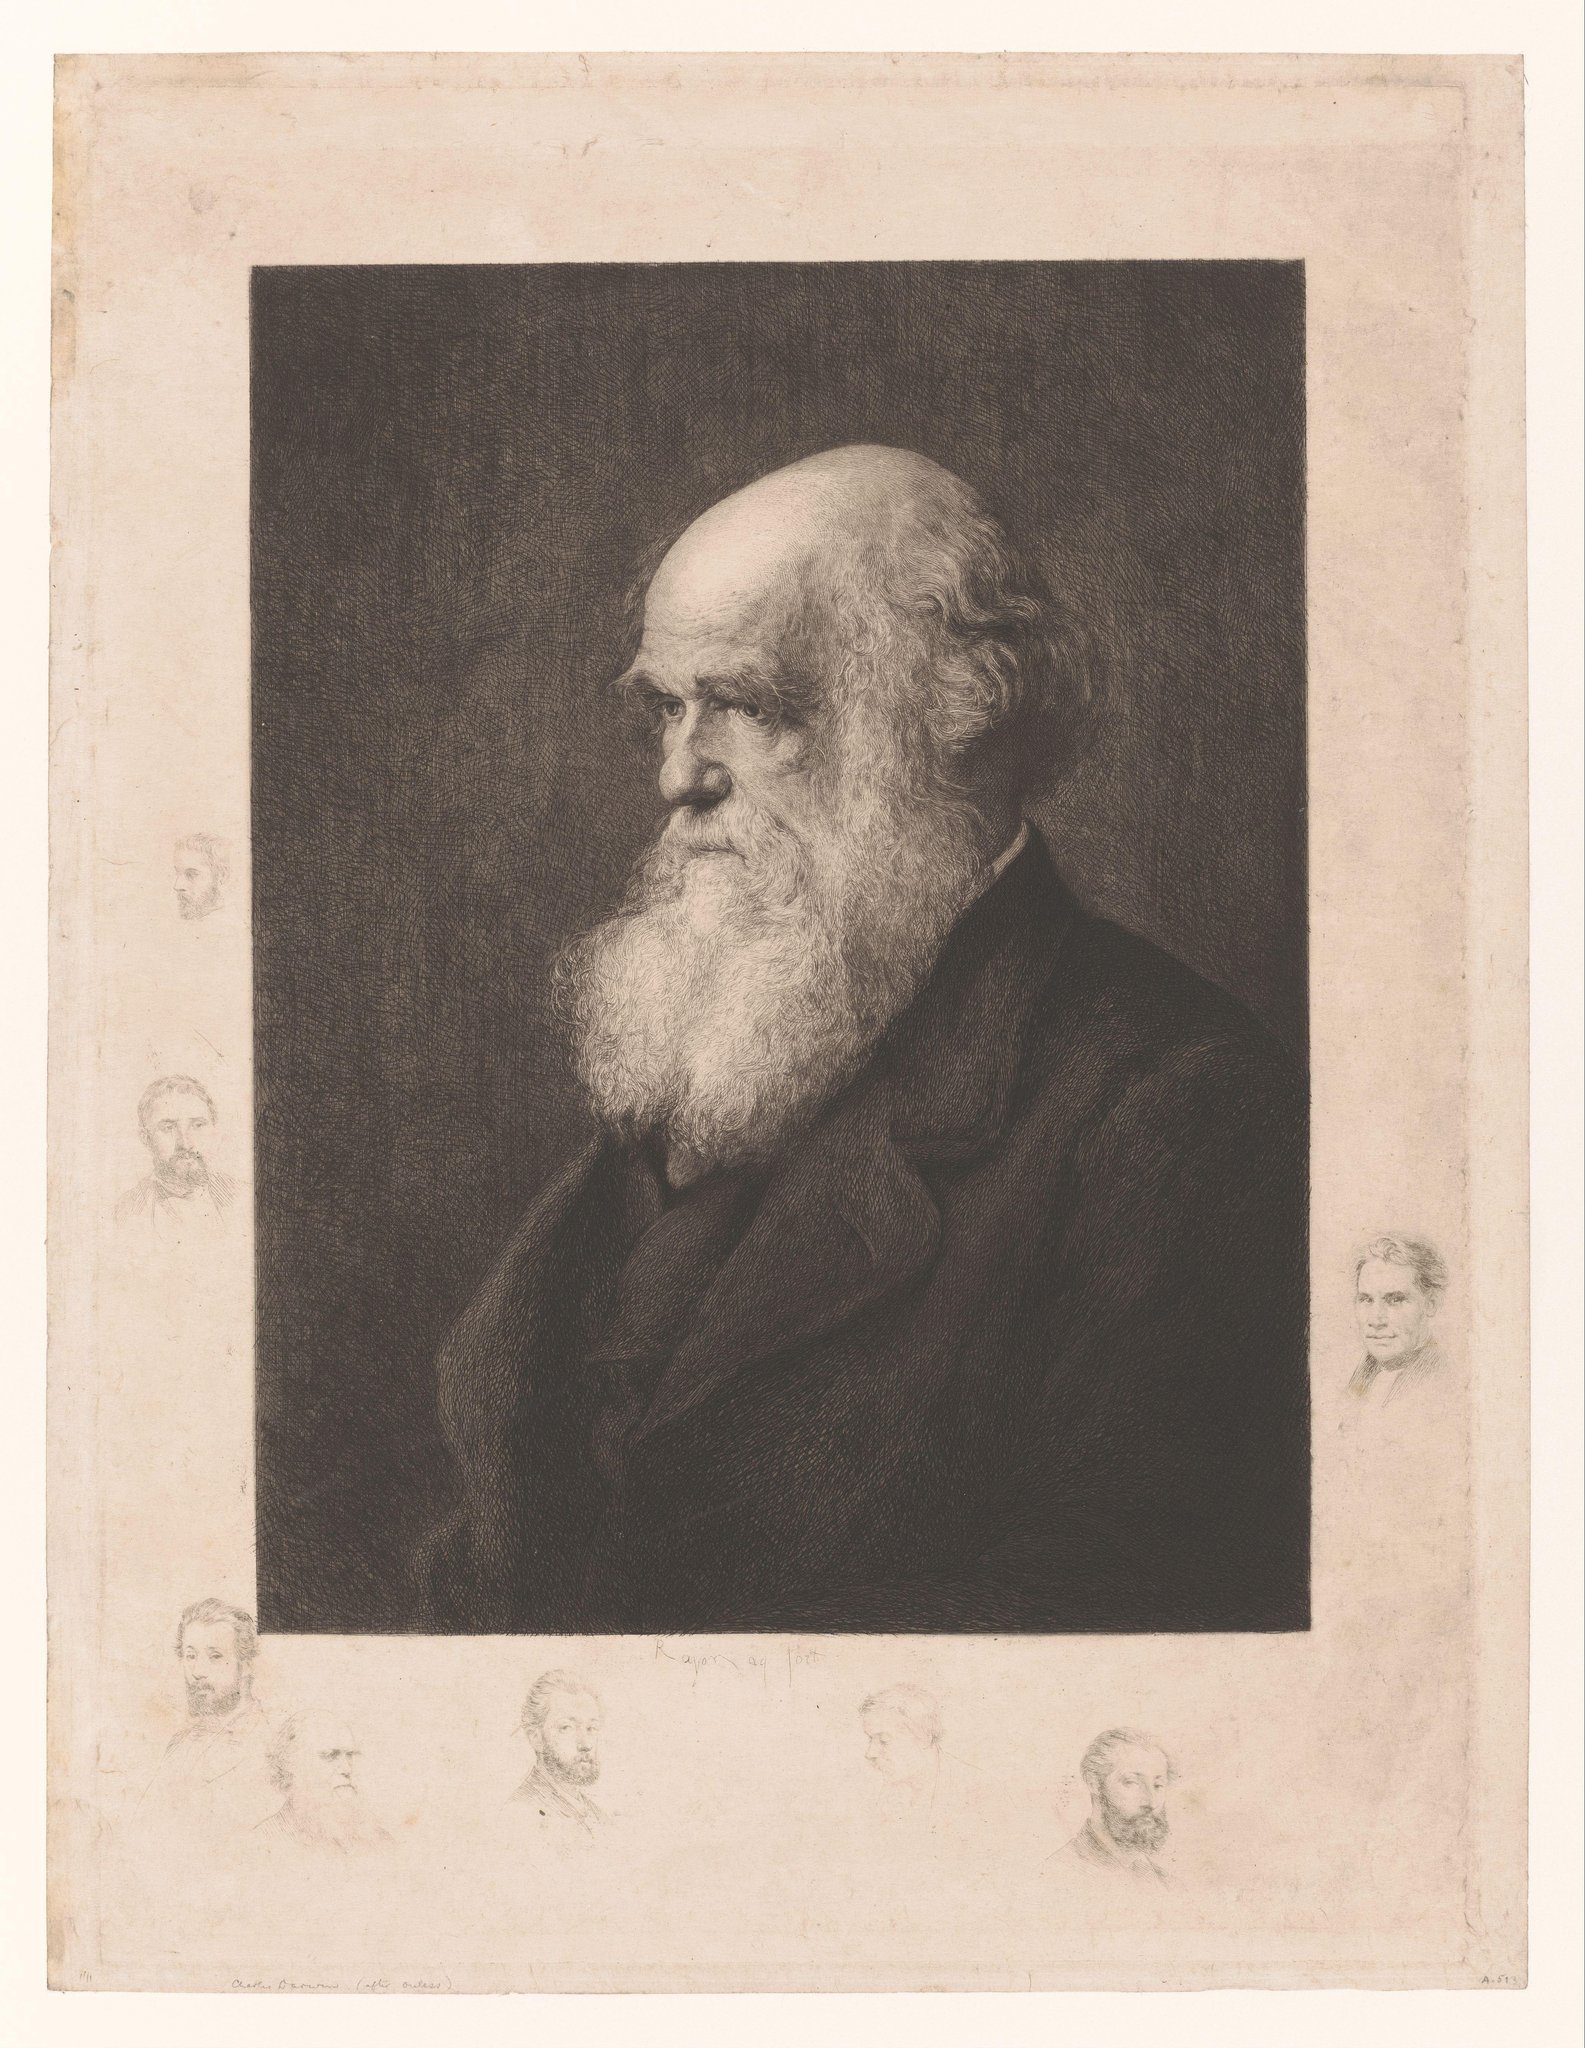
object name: print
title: Portret van Charles Darwin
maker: paul adolphe rajon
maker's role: print maker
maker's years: 1842-1888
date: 1882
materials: paper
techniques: etching, intaglio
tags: charles darwin, biology, historical persons, geological phenomena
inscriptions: collector's mark: Lugt 2228, collector's mark: Lugt 2760